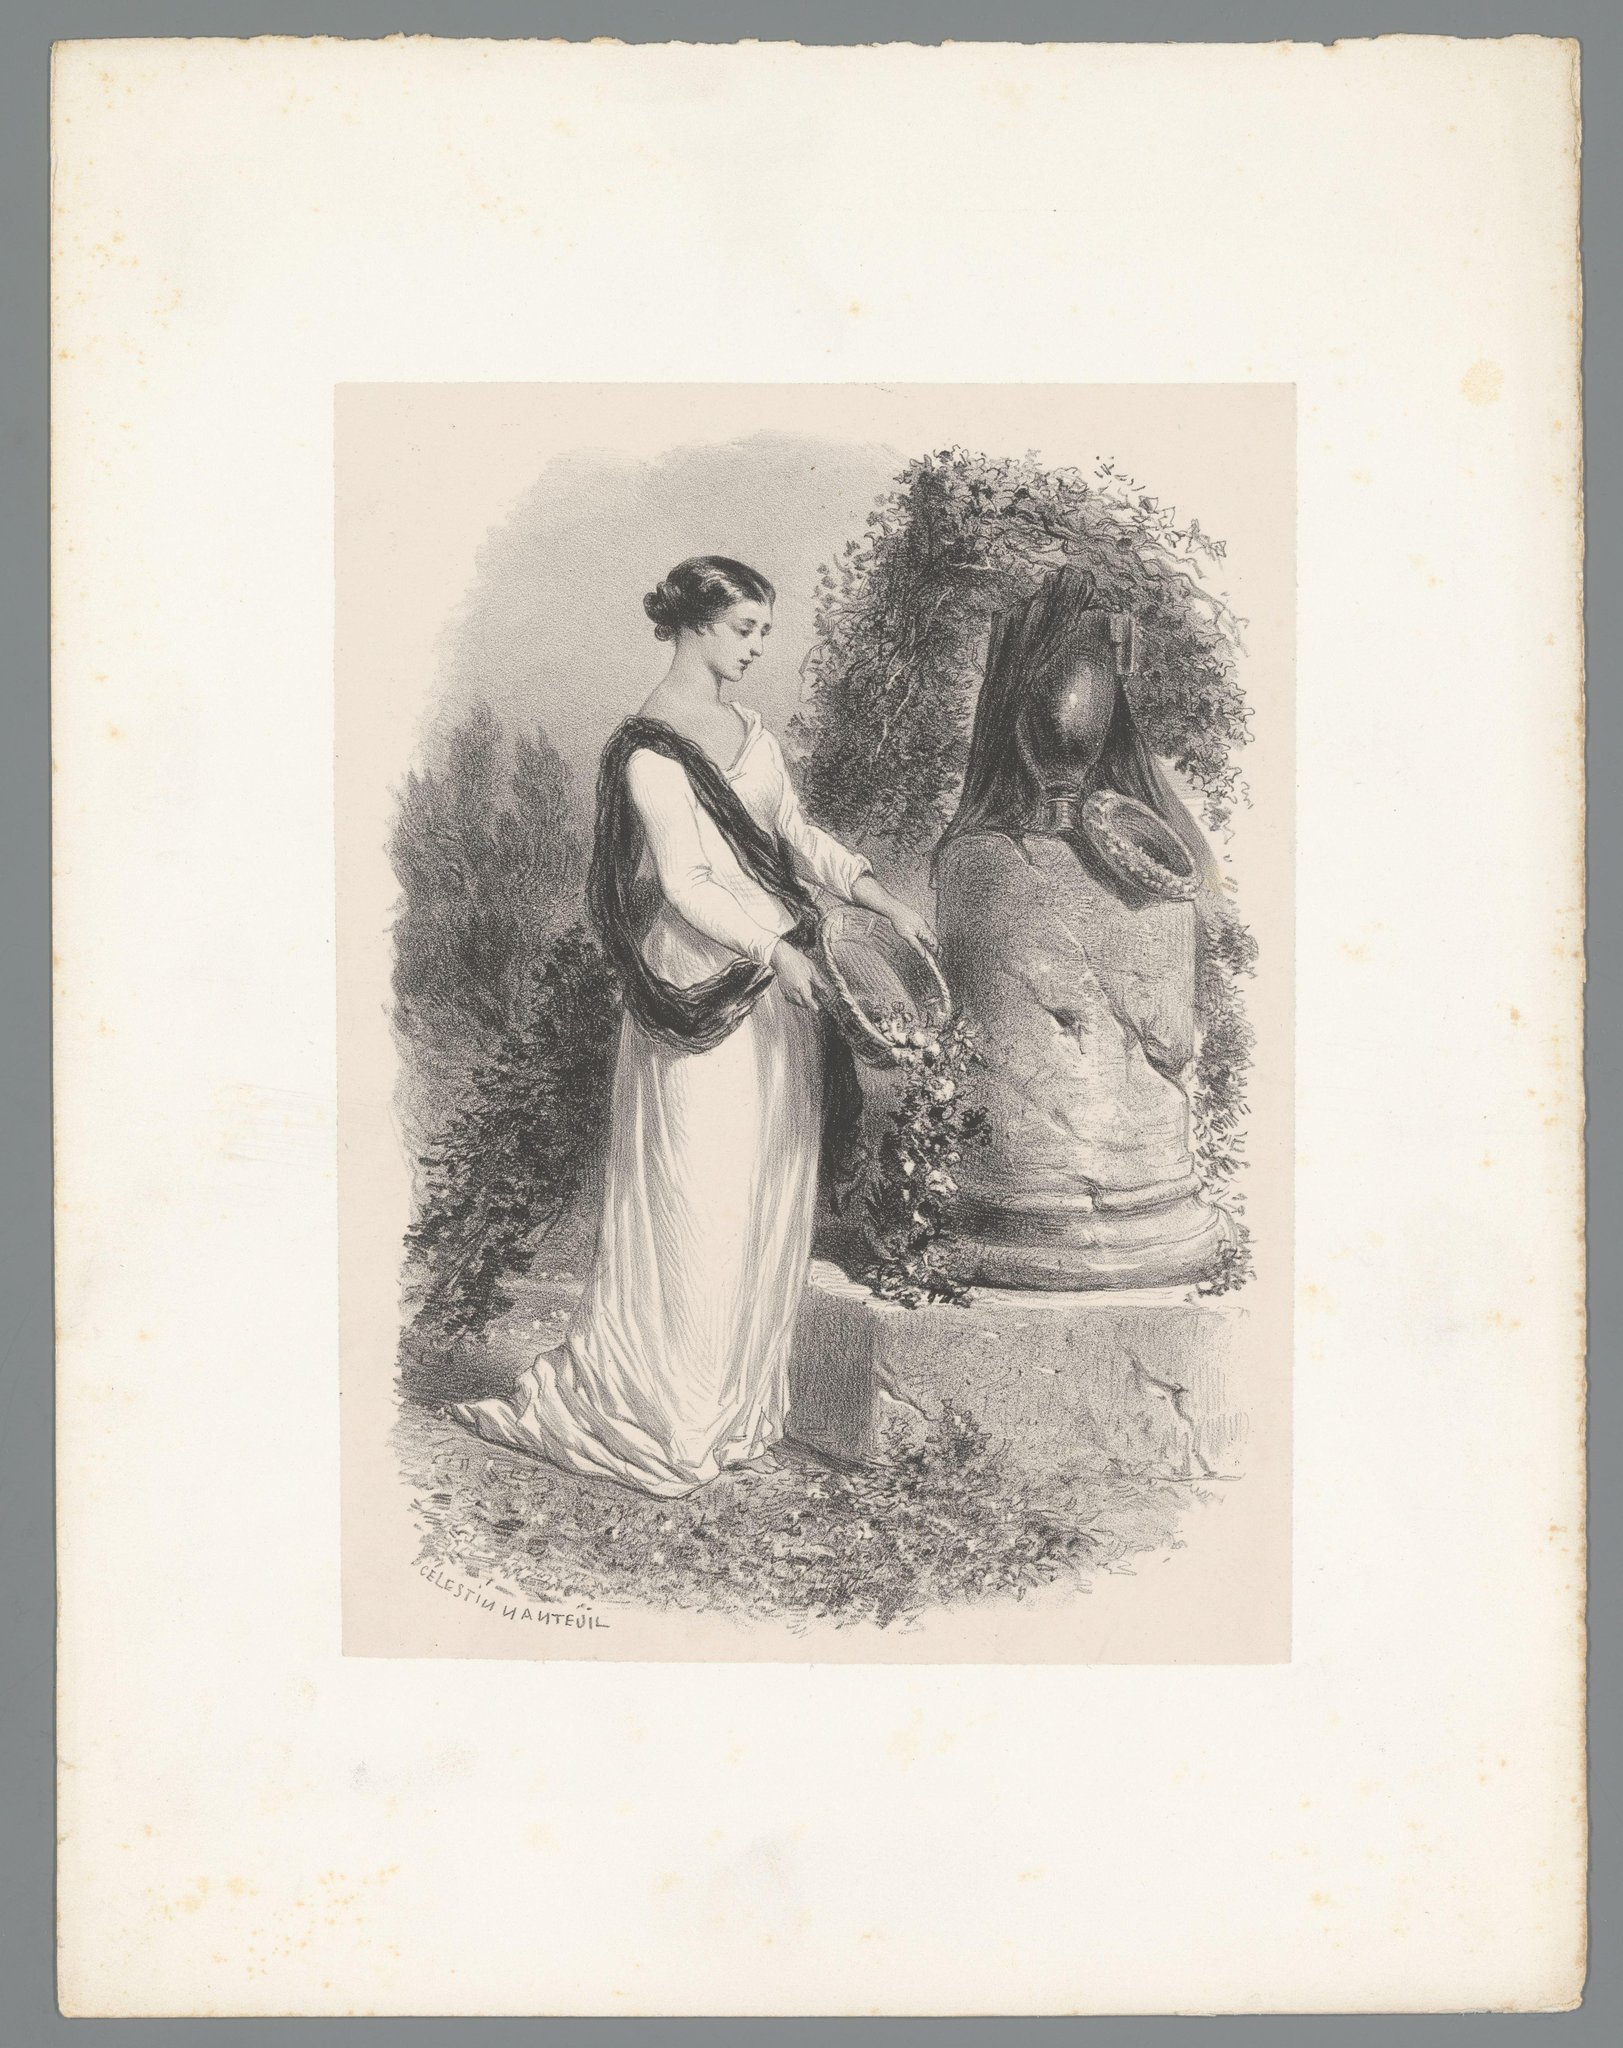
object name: print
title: Vrouw strooit bloemen bij een zuil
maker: célestin françois nanteuil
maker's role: print maker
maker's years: 1813-1873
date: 1823-1873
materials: paper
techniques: lithograph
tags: flowers, column, pillar ~ architecture, garland, wreath, female sex; woman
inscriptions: collector's mark: Lugt 964